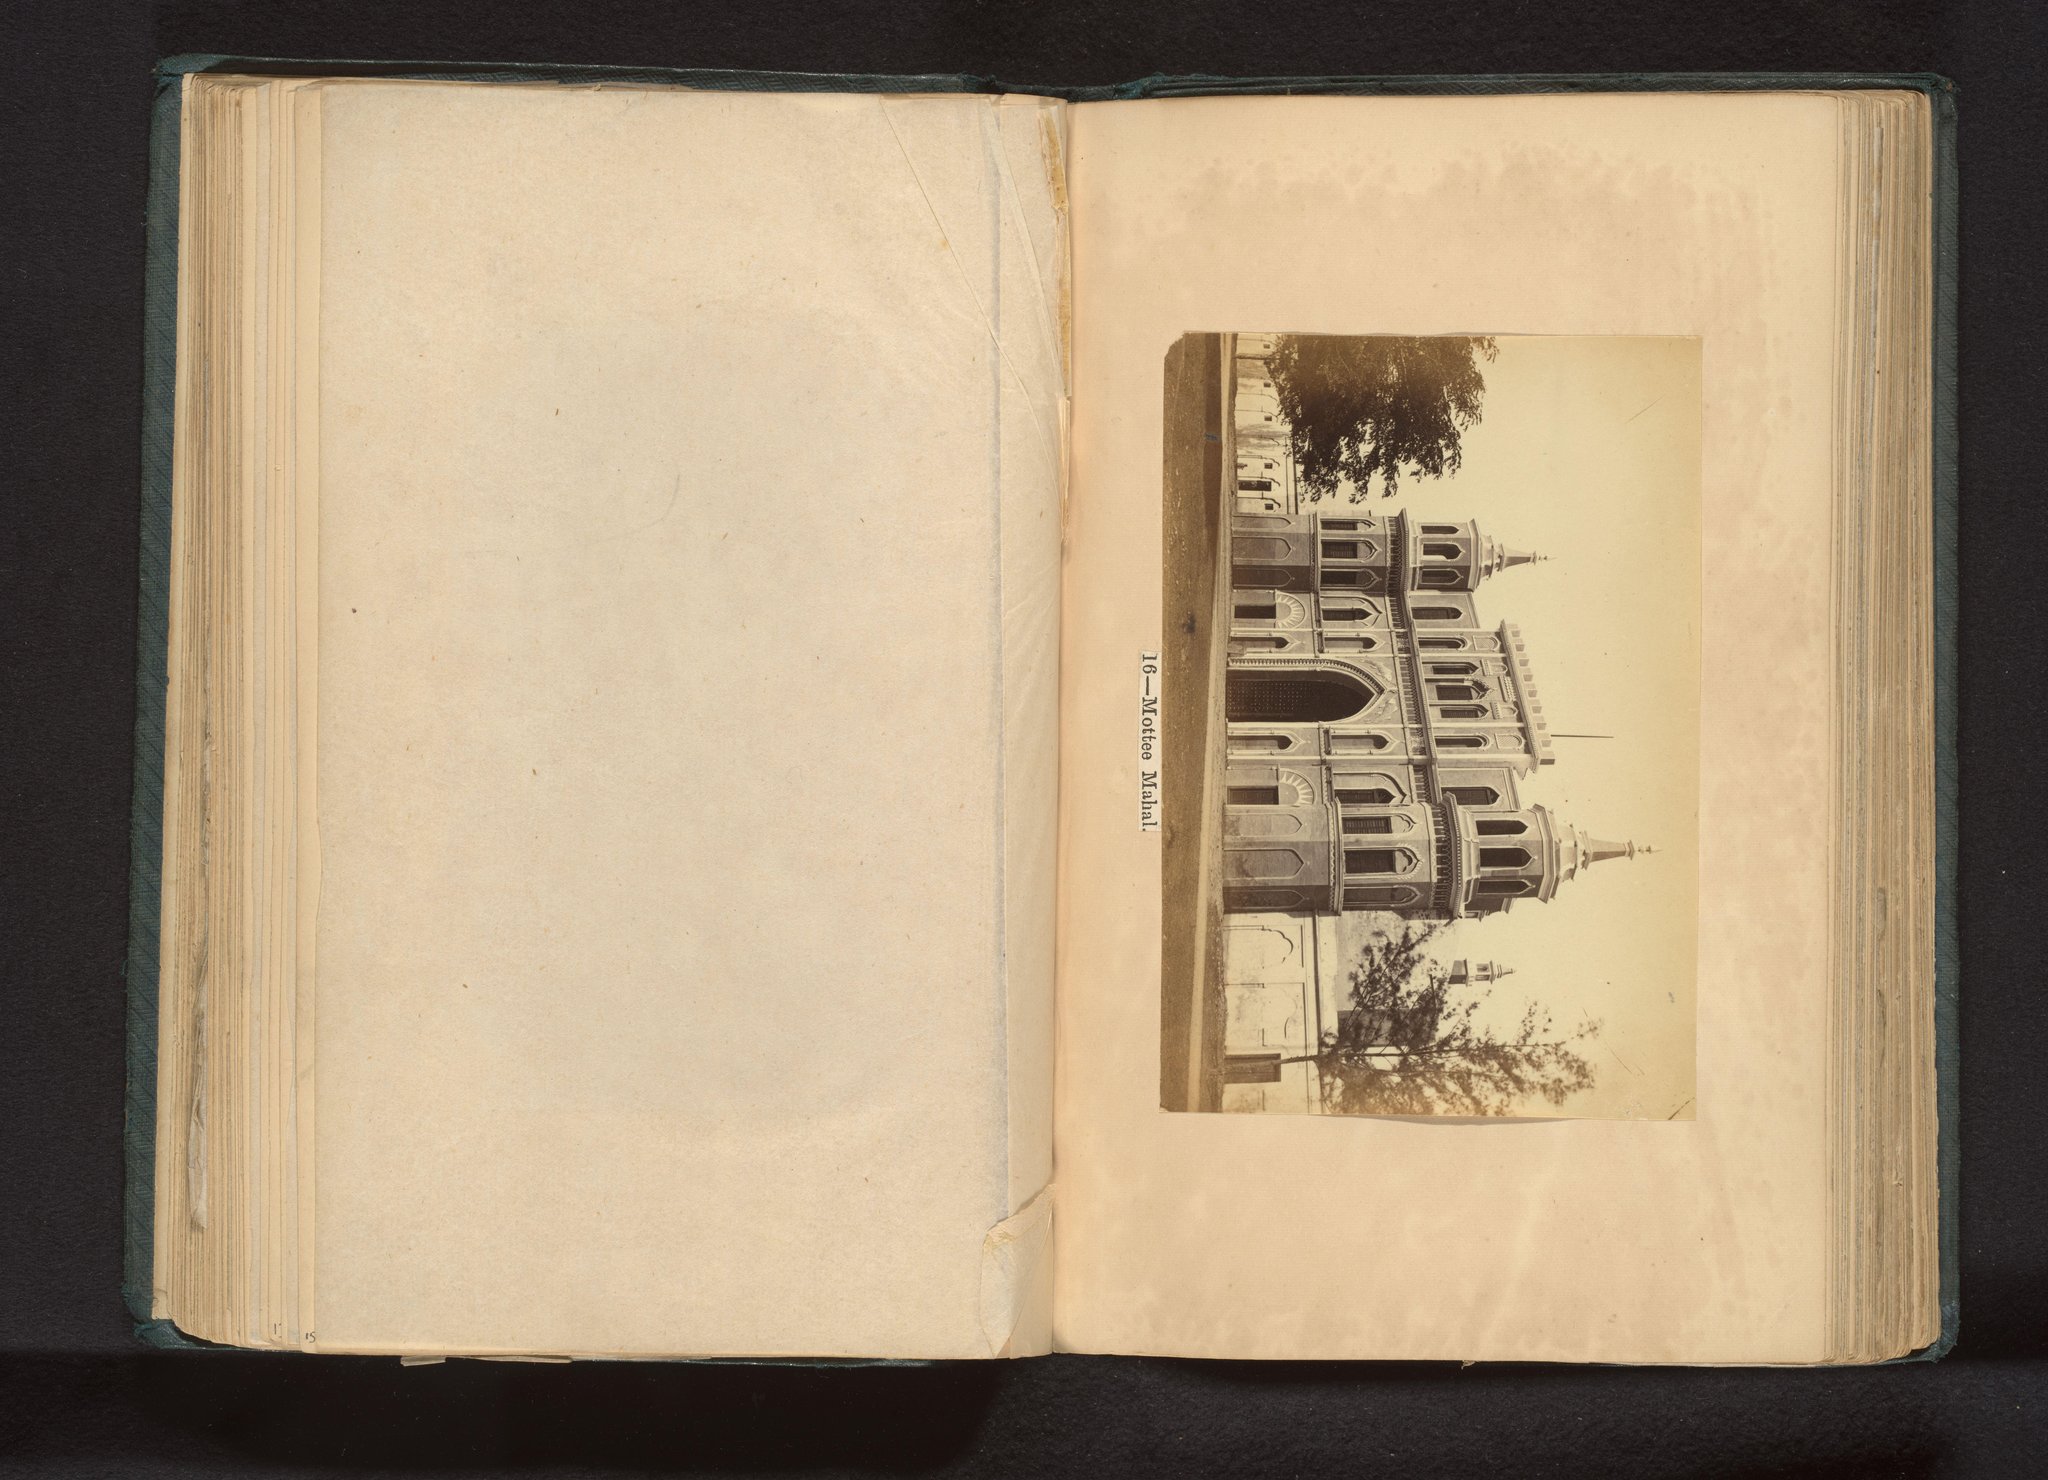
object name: page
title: Gezicht op het Moti Mahal in Lucknow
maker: darogha ubbas alli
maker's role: fotograaf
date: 1864-1874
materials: photographic support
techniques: albumen print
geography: lucknow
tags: palace, gate, entrance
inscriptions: number: ‘16’